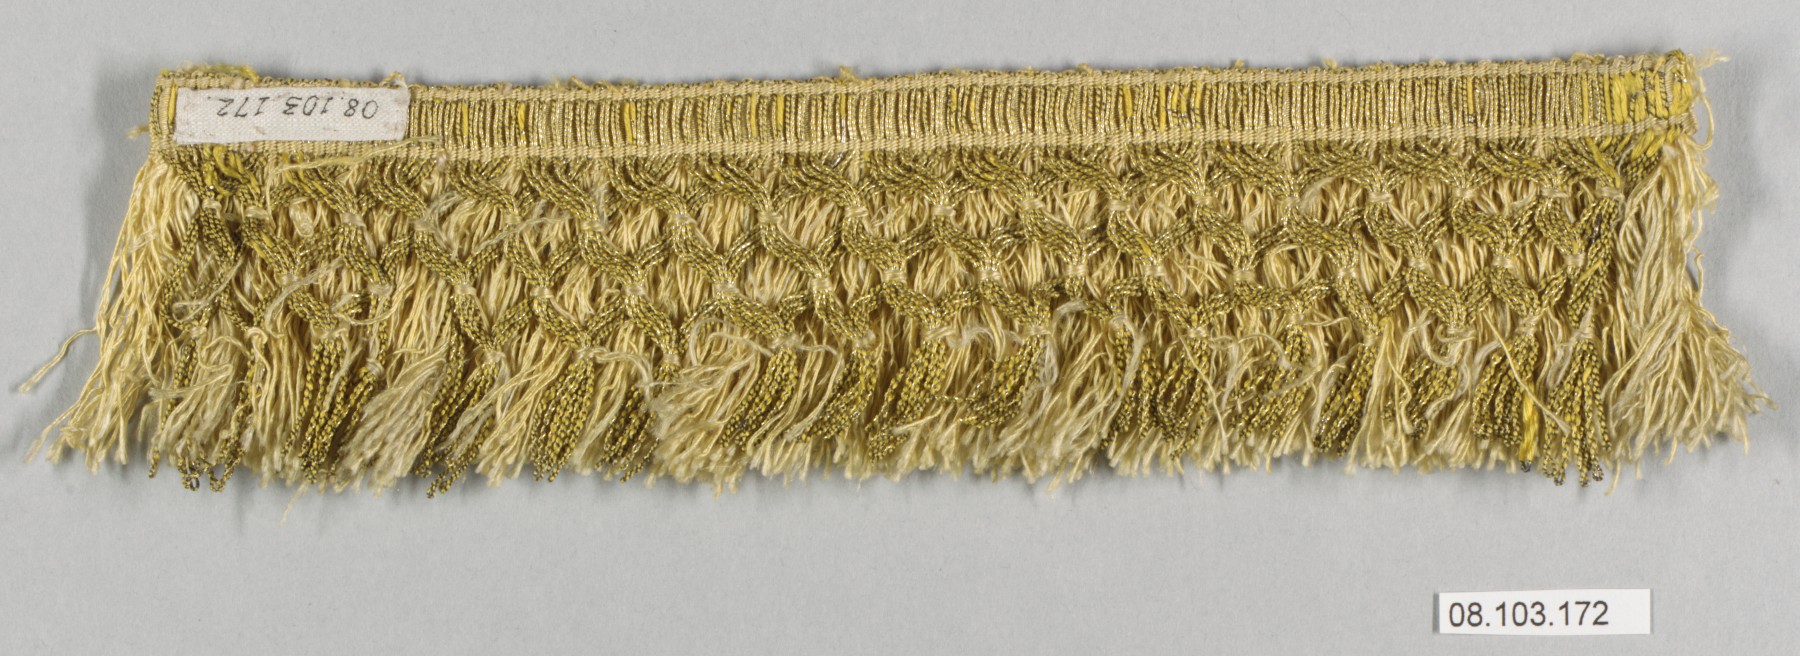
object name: fringe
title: Double fringe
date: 1801-1900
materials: metal thread, silk